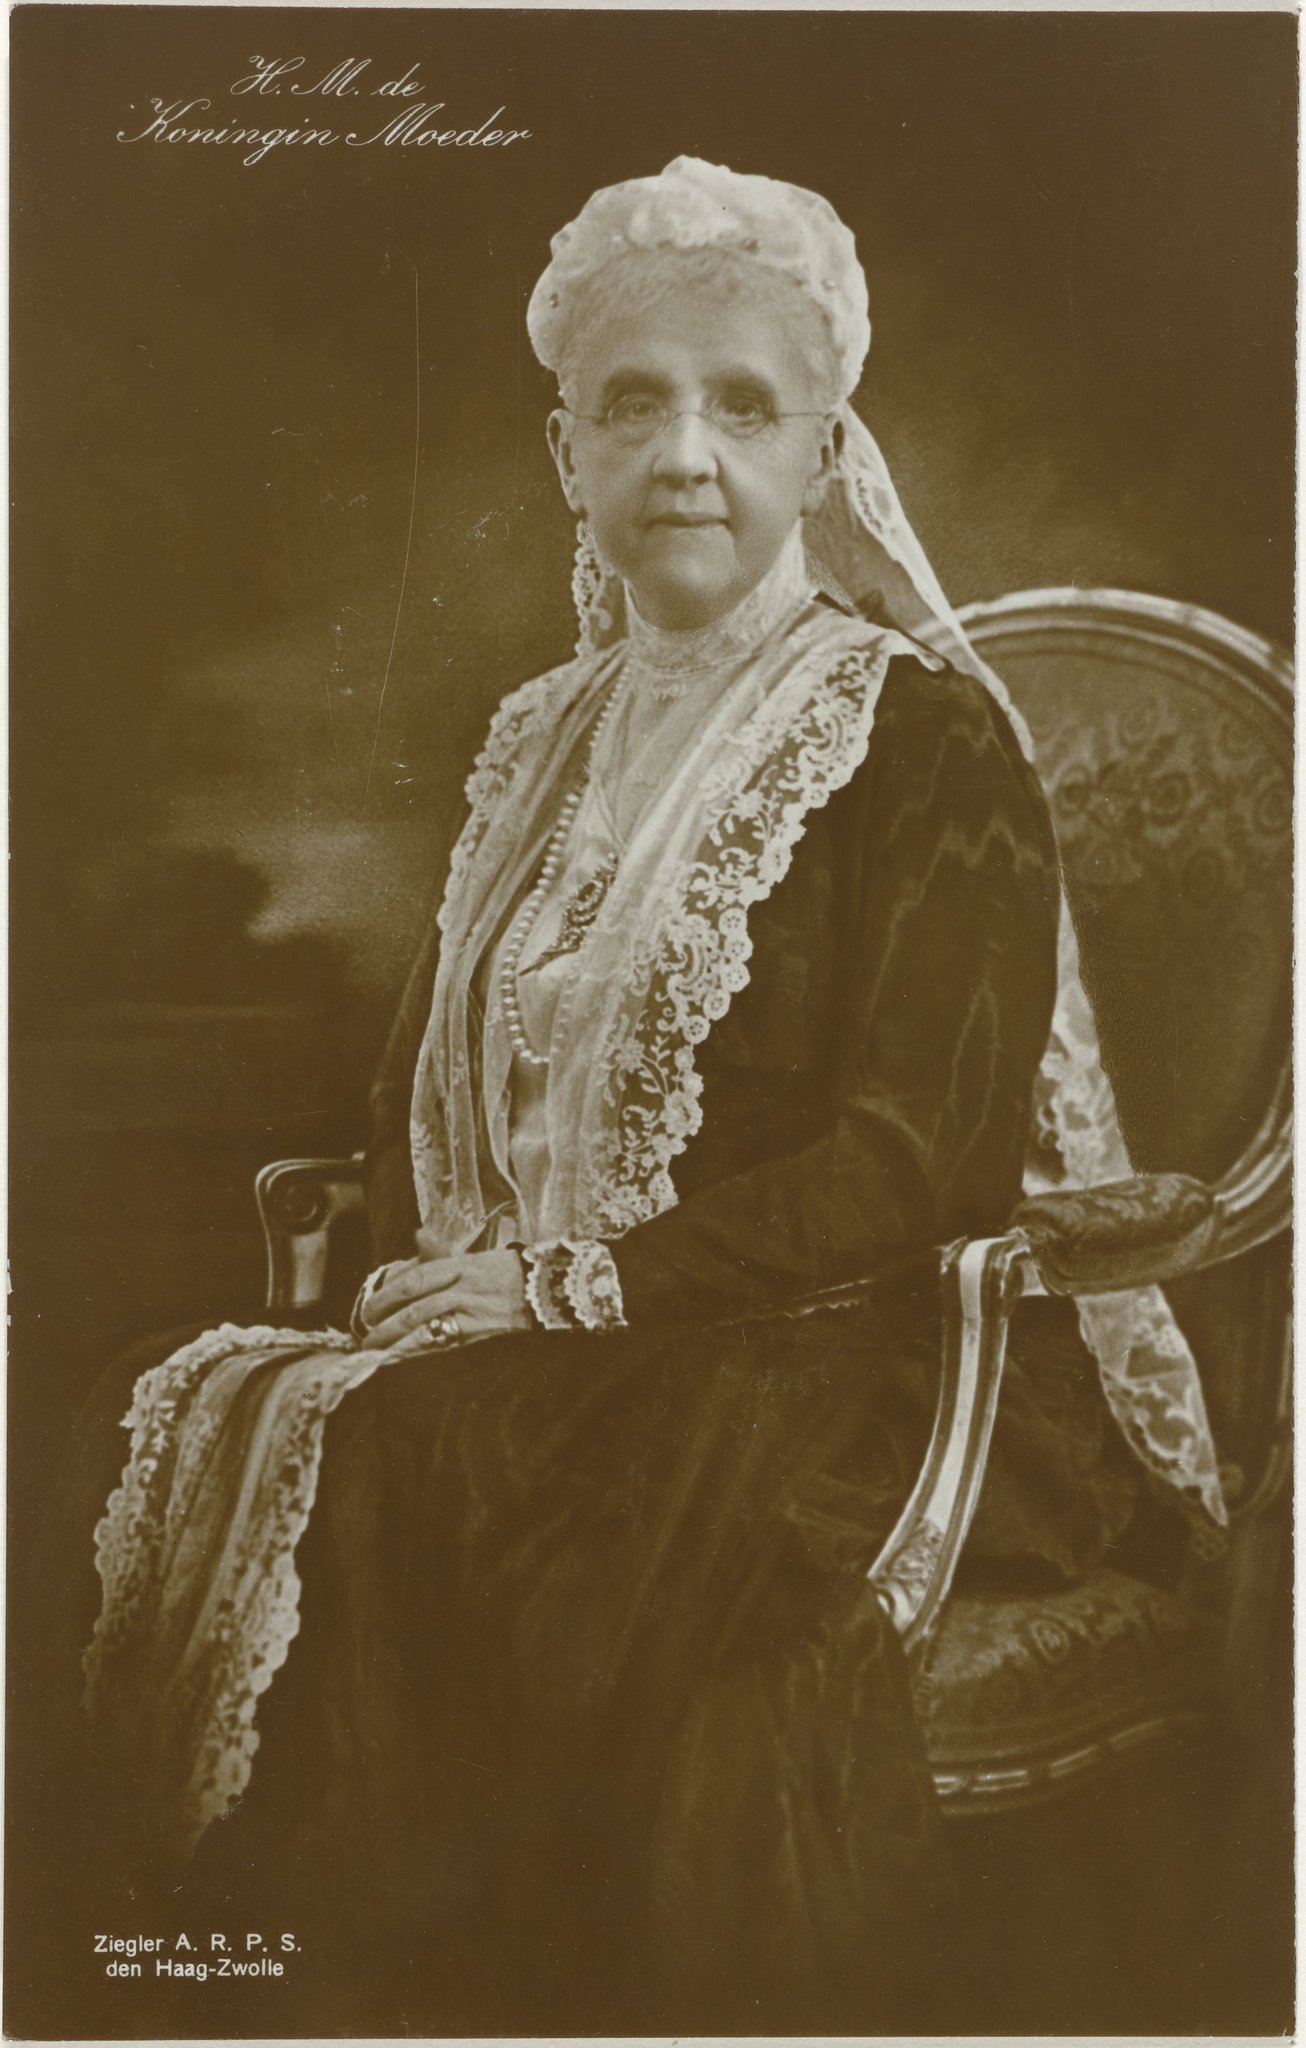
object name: ansichtkaart, prentbriefkaart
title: Portret van Emma, koningin-regentes der Nederlanden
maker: franz ziegler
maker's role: fotograaf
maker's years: 1893-1939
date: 1925-1934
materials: photographic support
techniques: photography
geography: netherlands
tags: the hague, emma (queen consort of the netherlands)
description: De hier vermelde titel verwijst naar de hoogst verkregen titel van de geportretteerde, niet per se naar de titel die de geportretteerde op deze voorstelling draagt.